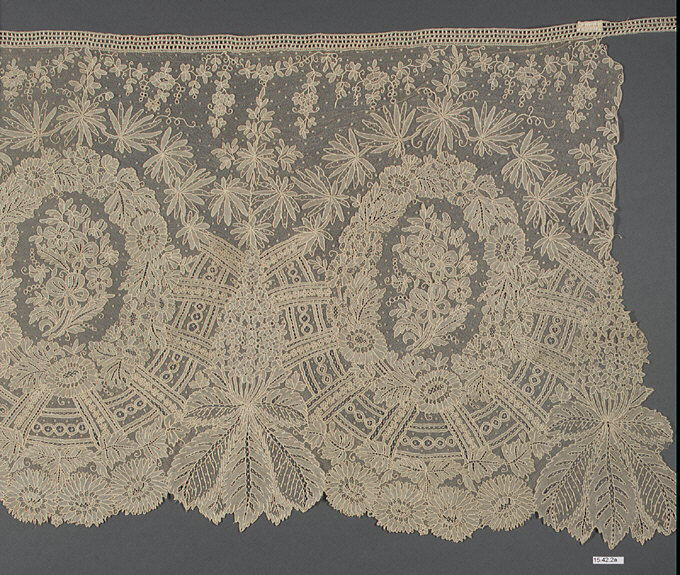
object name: flounce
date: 1801-1900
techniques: lace